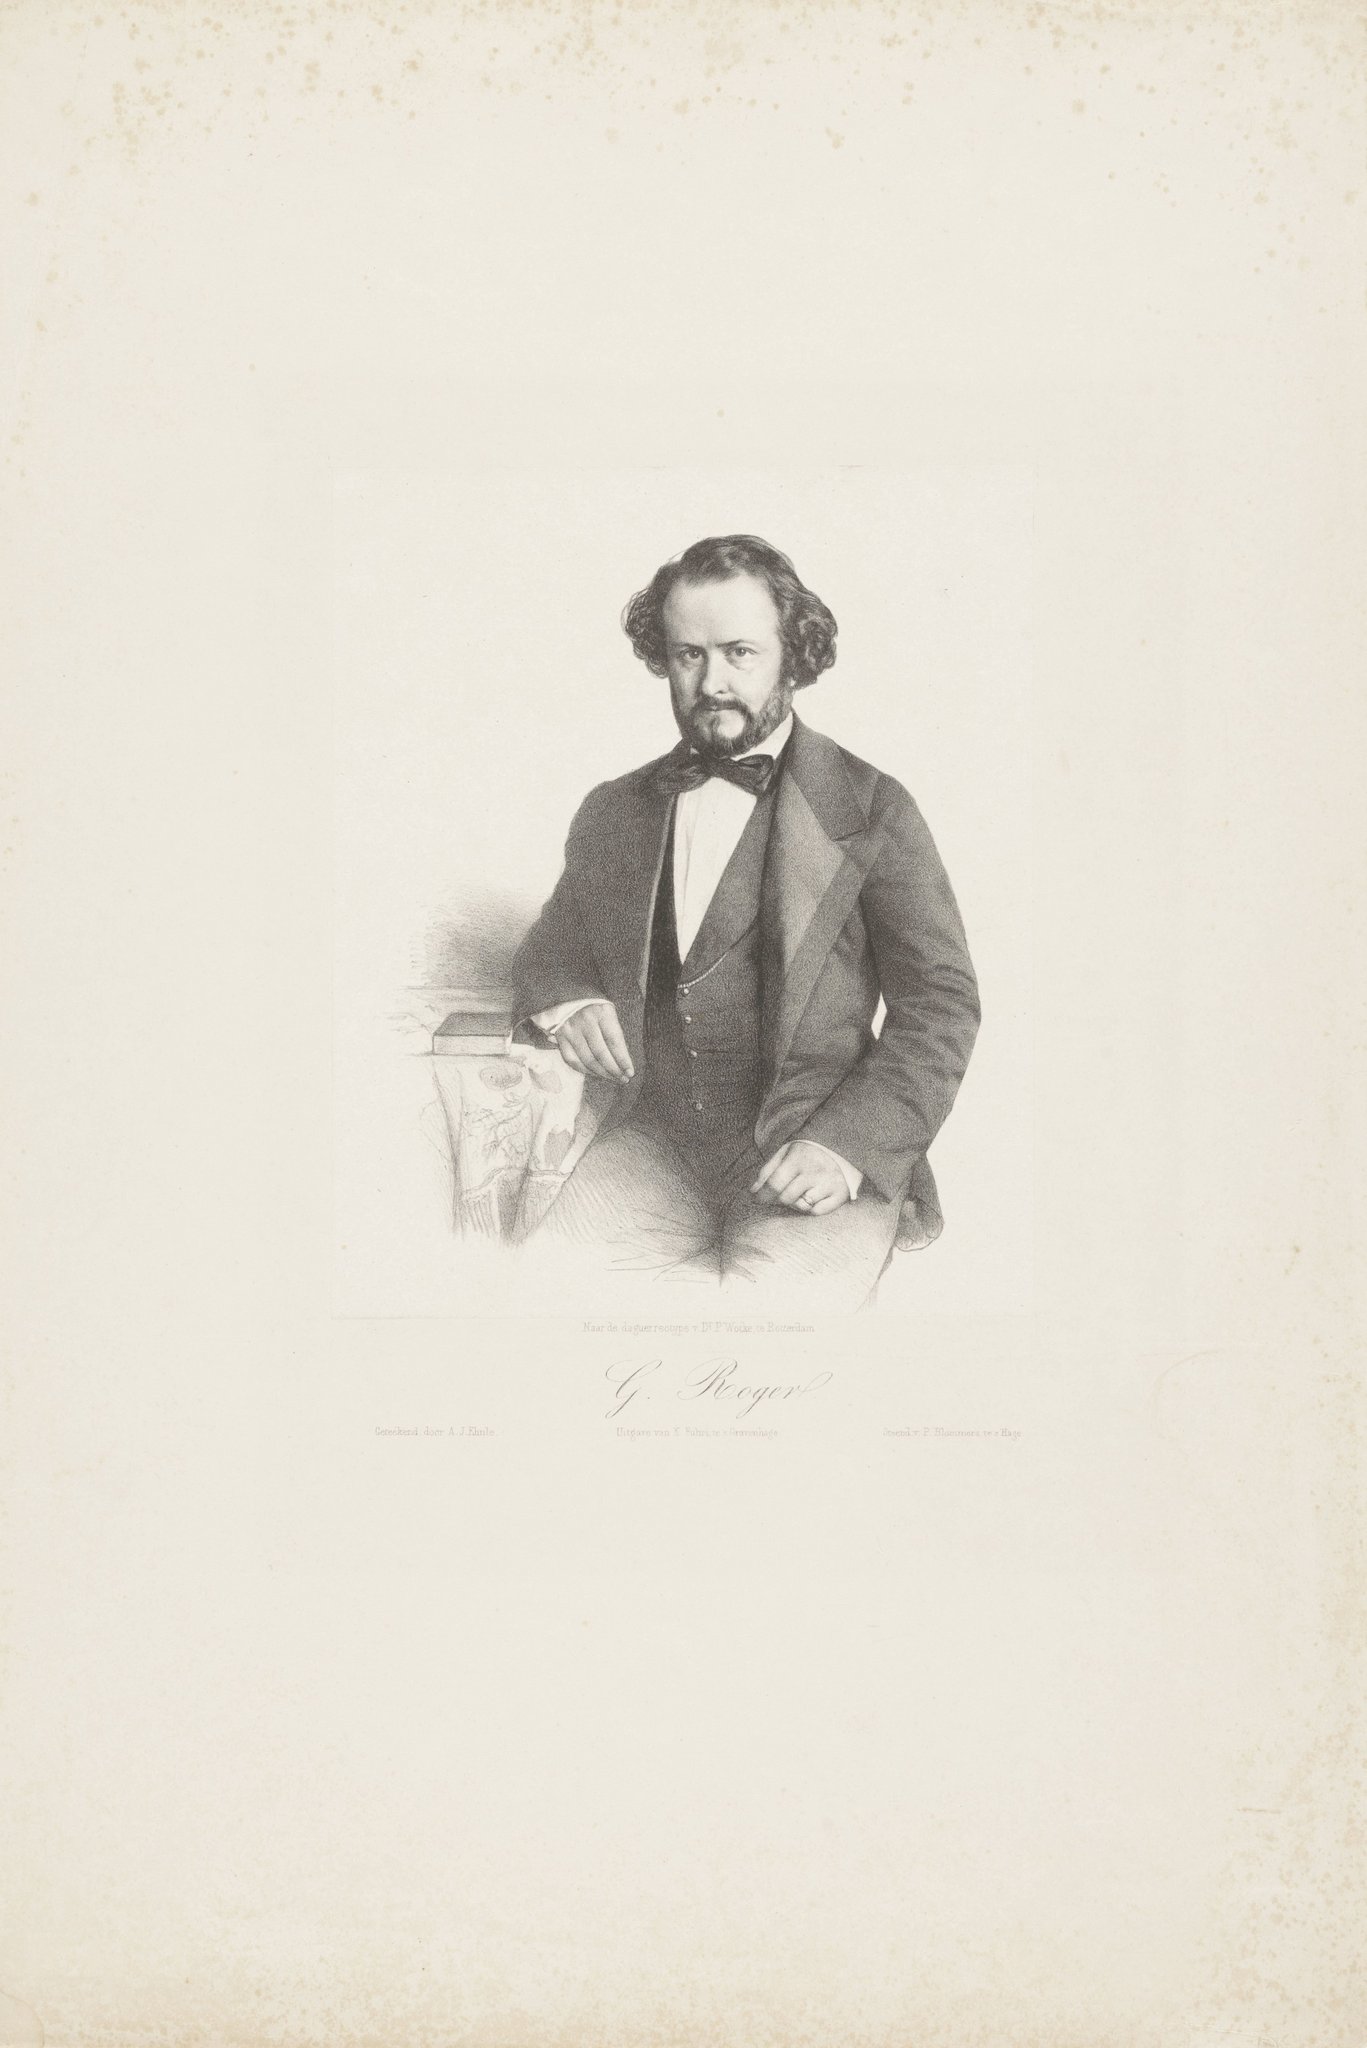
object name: print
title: Portret van G. Roger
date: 1855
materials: paper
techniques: lithograph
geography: the hague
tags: book, historical persons (+ half-length portrait)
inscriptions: collector's mark: Lugt 2228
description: De geportretteerde leunt met zijn rechterarm op een tafel. Daarop ligt een boek. Onderdeel van een serie van twaalf portretten naar daguerrotypieën en twaalf stadsgezichten. Ter gelegenheid van het Muziekfeest ter viering van het 25-jarige bestaan van de Maatschappij ter Bevordering van Toonkunst in Rotterdam, 12-15 juli 1854.